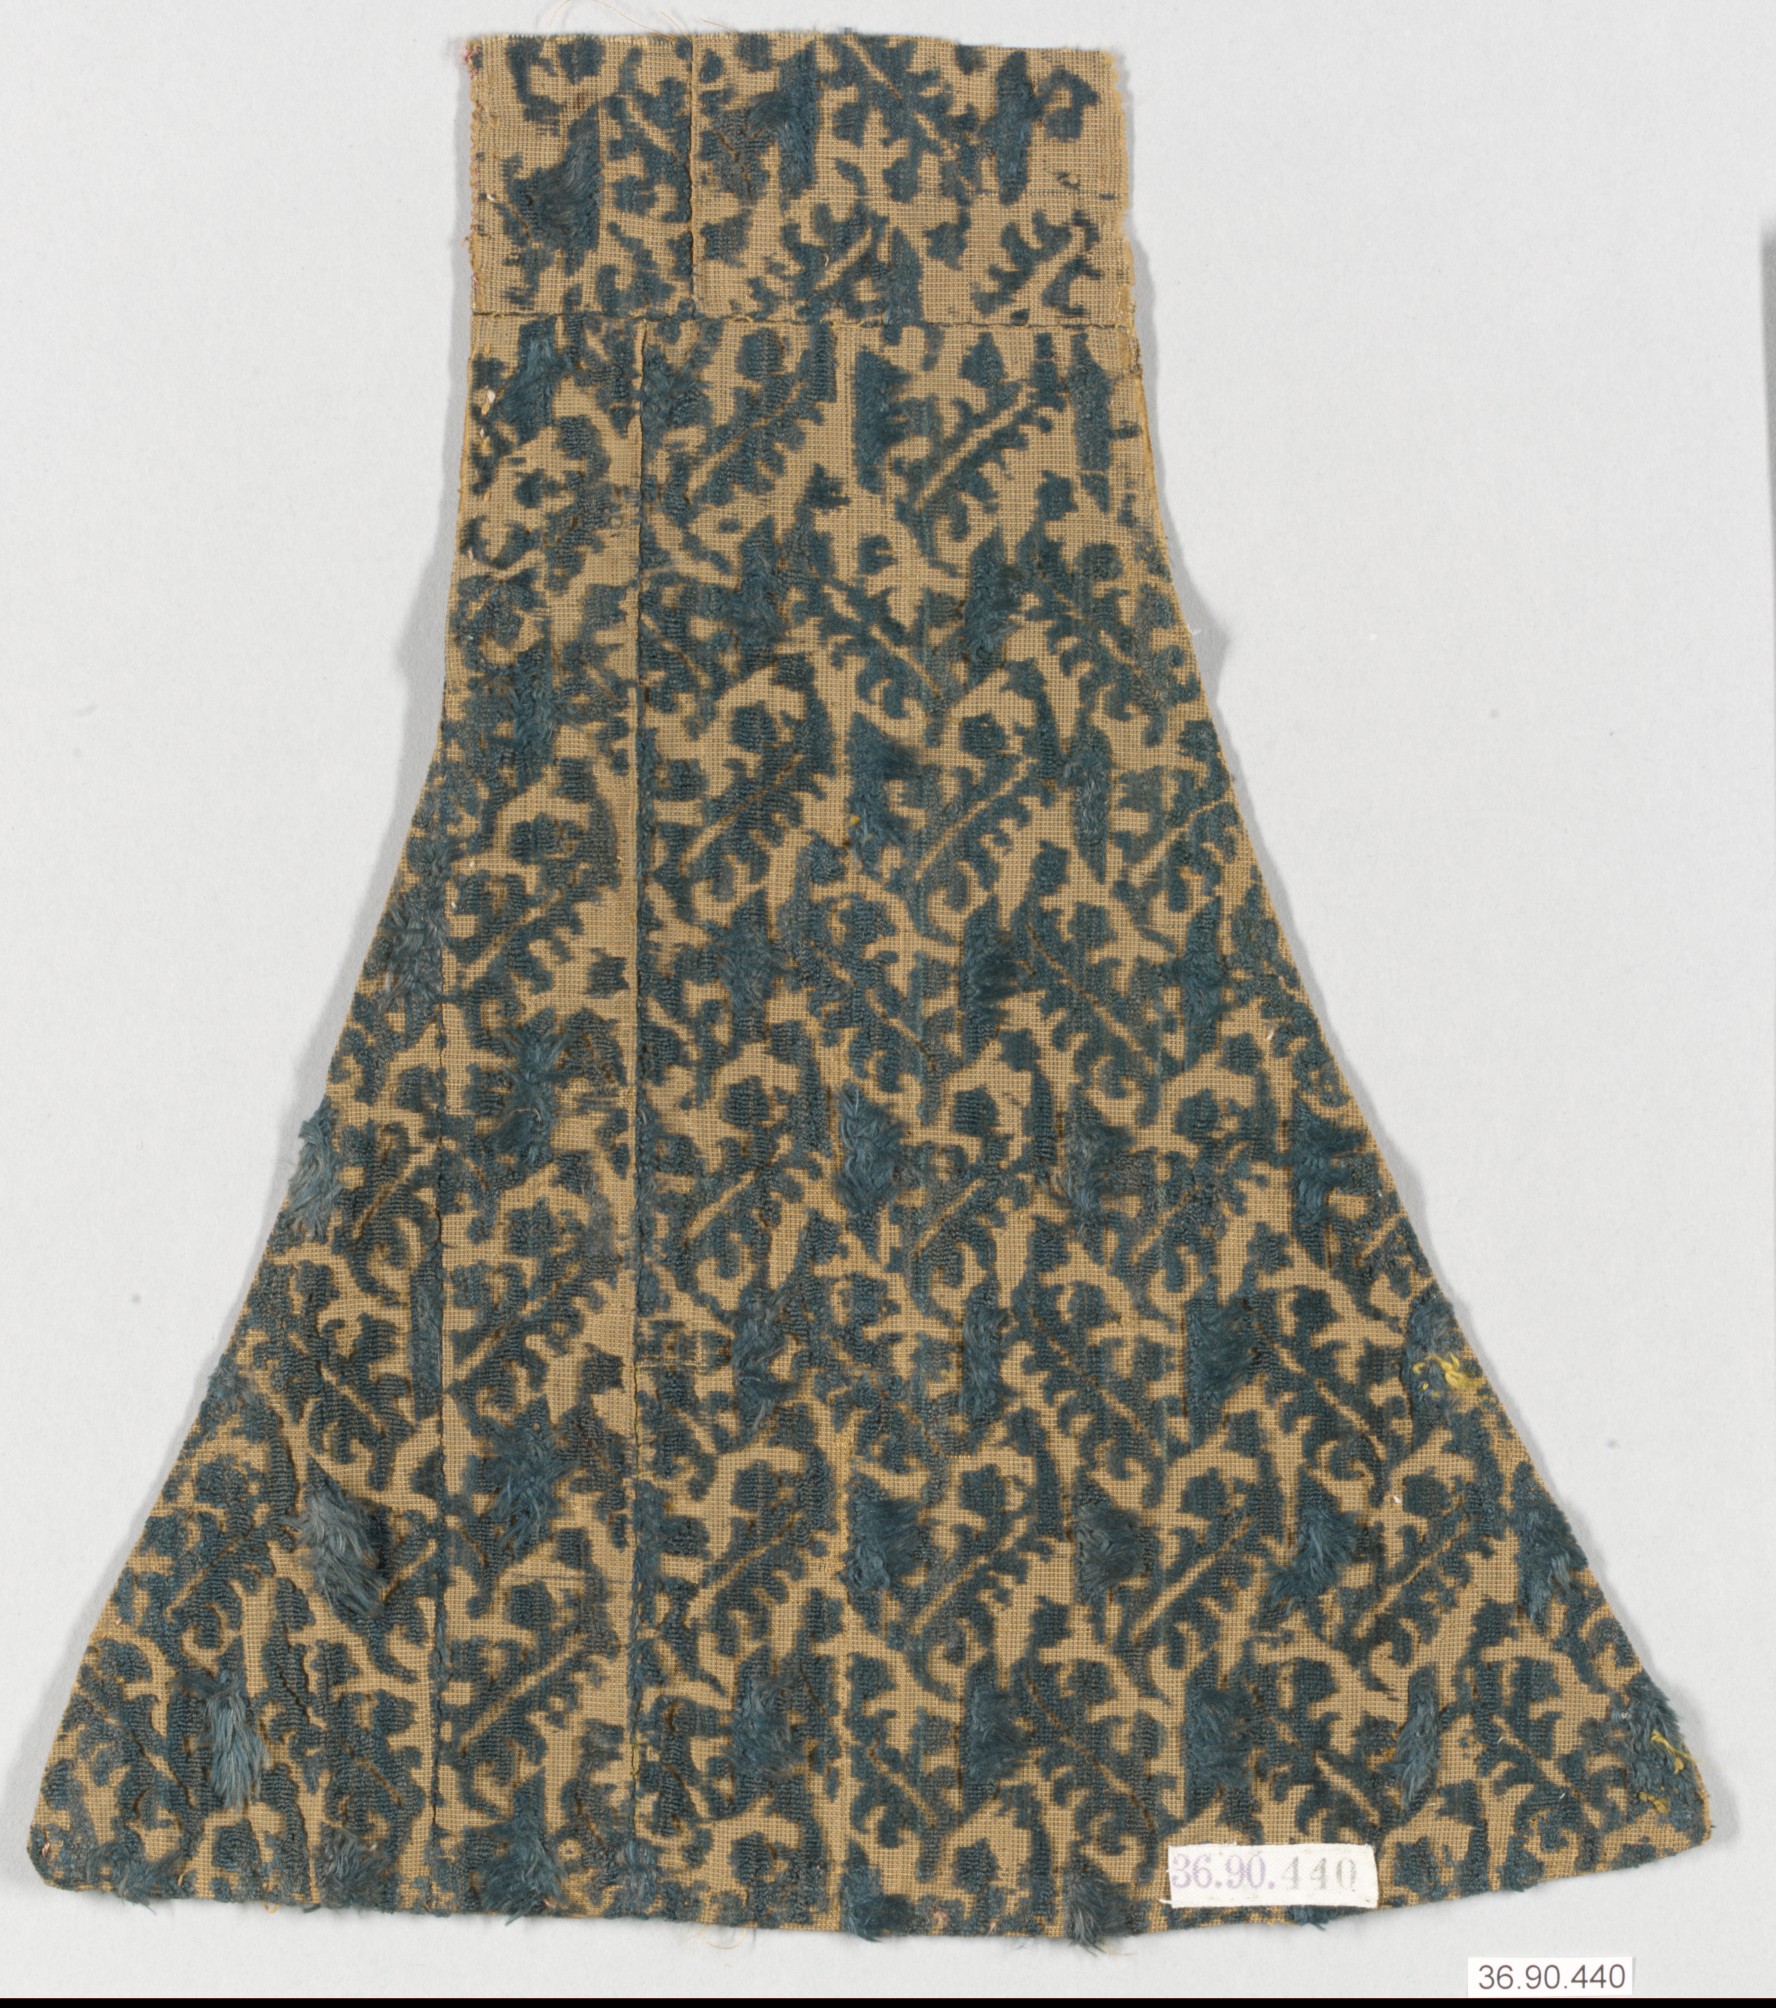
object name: piece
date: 1501-1700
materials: silk